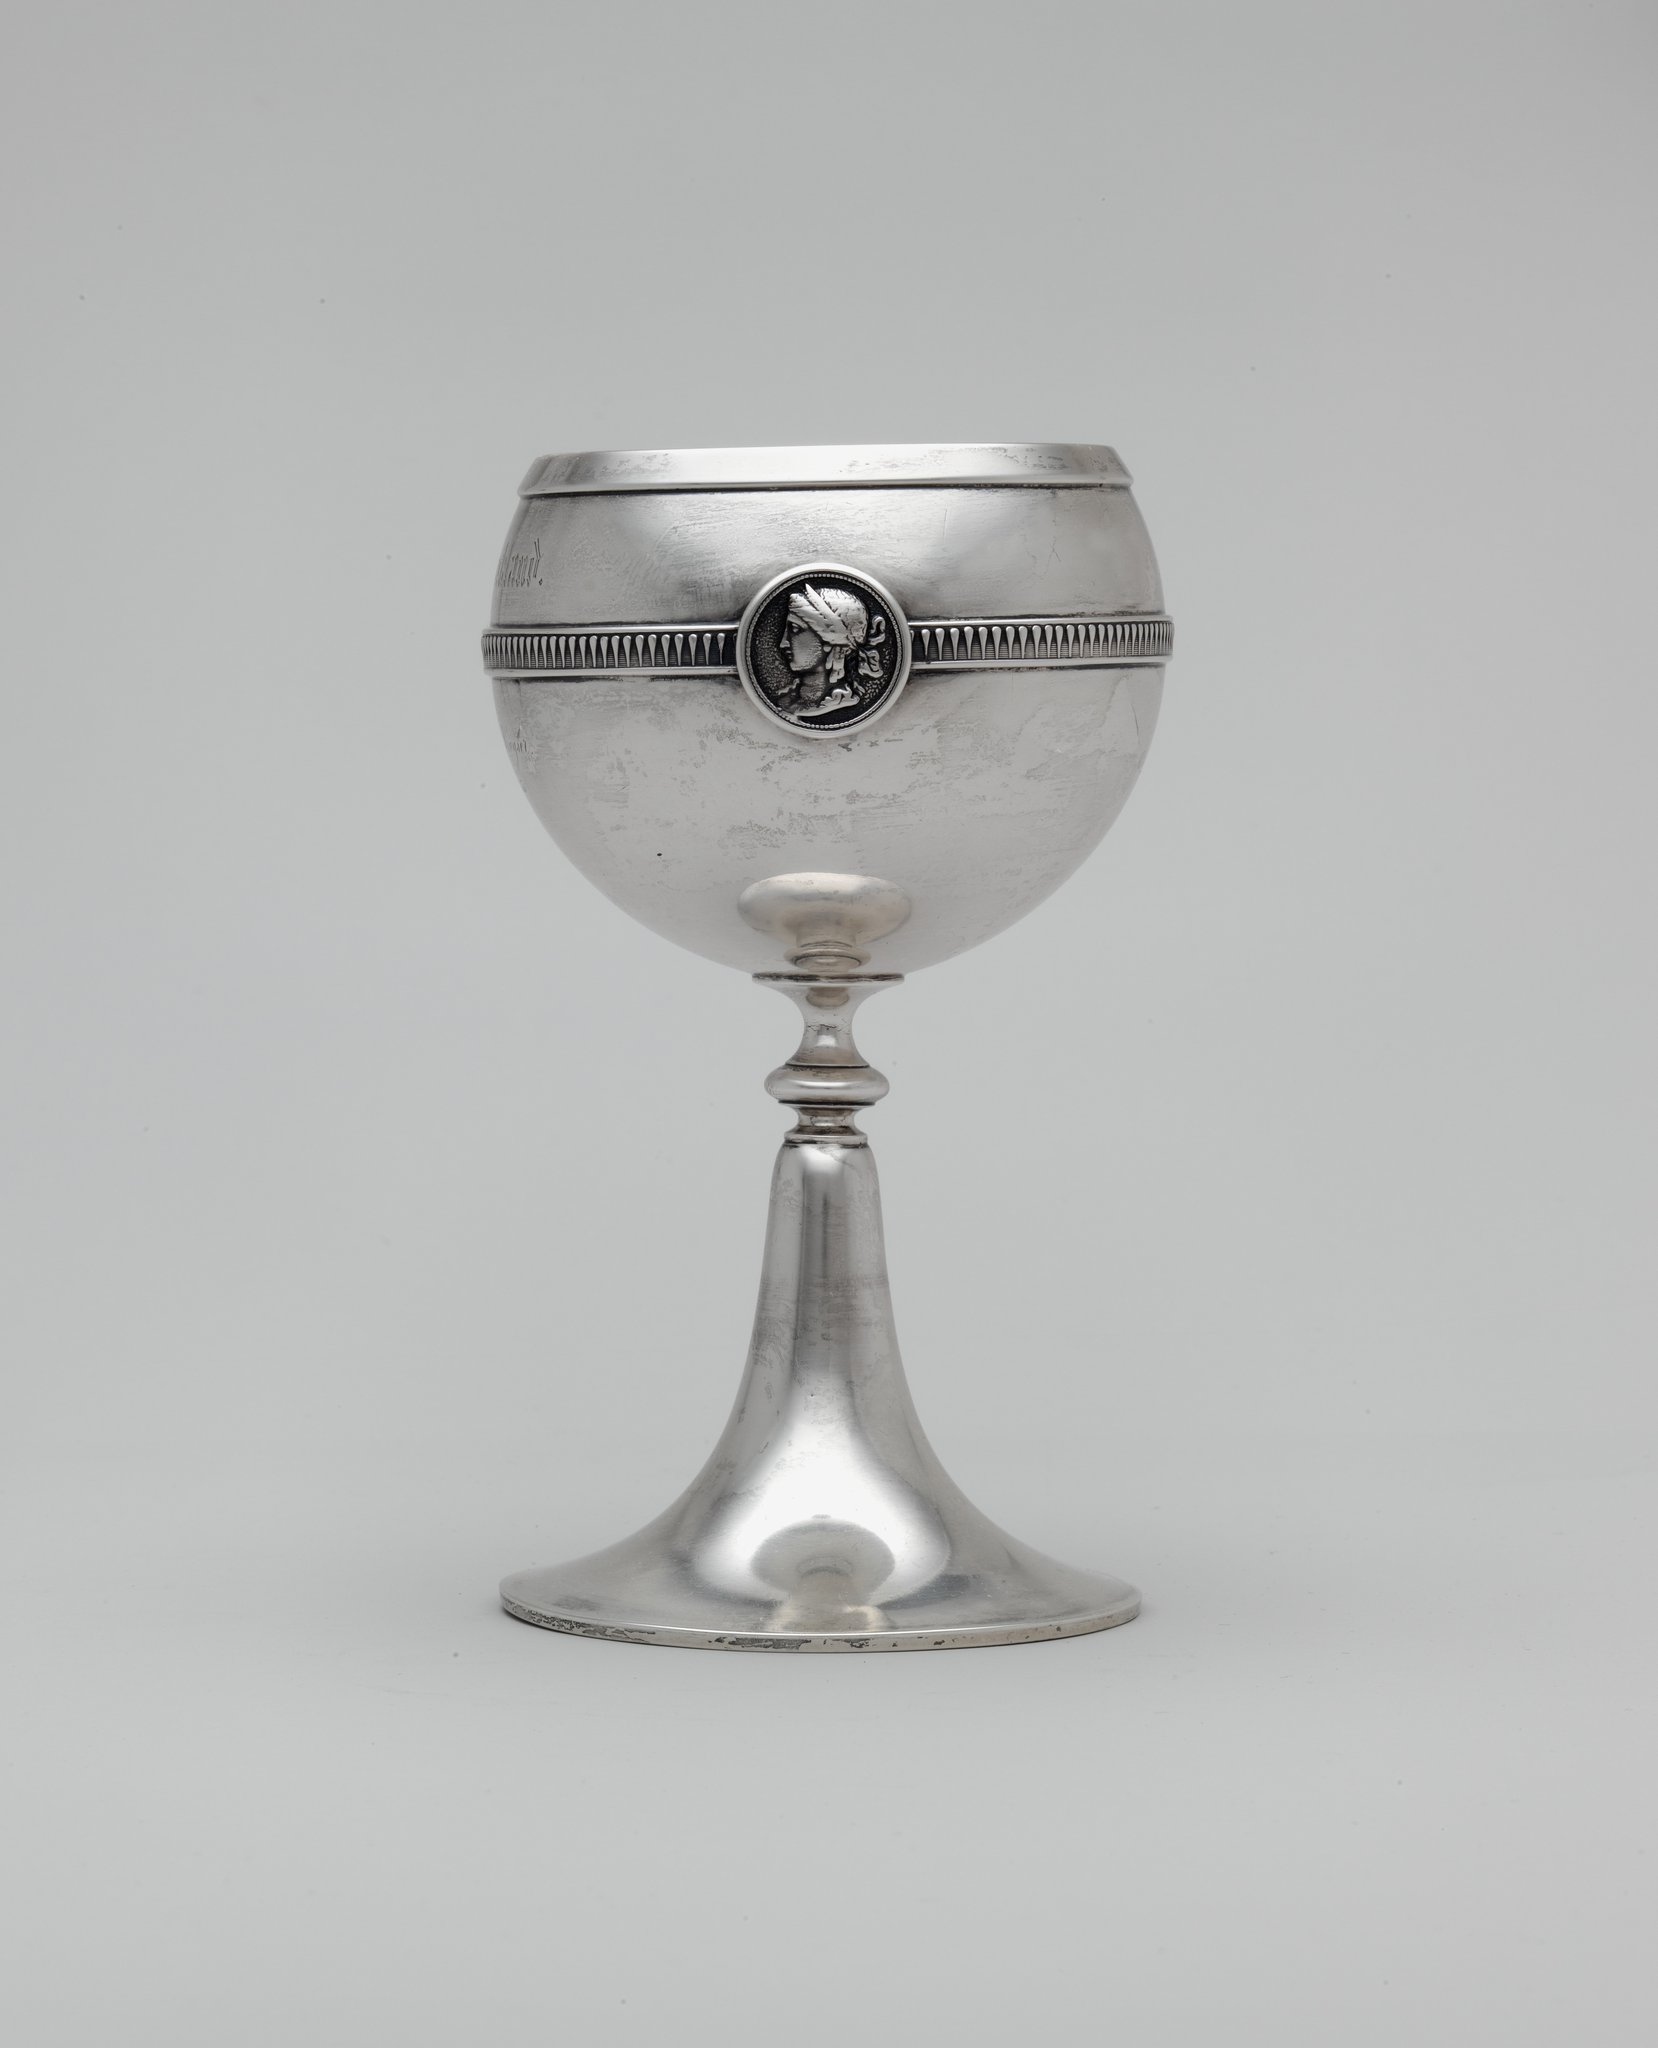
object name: goblet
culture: american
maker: gorham manufacturing company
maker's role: maker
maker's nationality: american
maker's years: 1831-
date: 1865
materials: silver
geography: united states